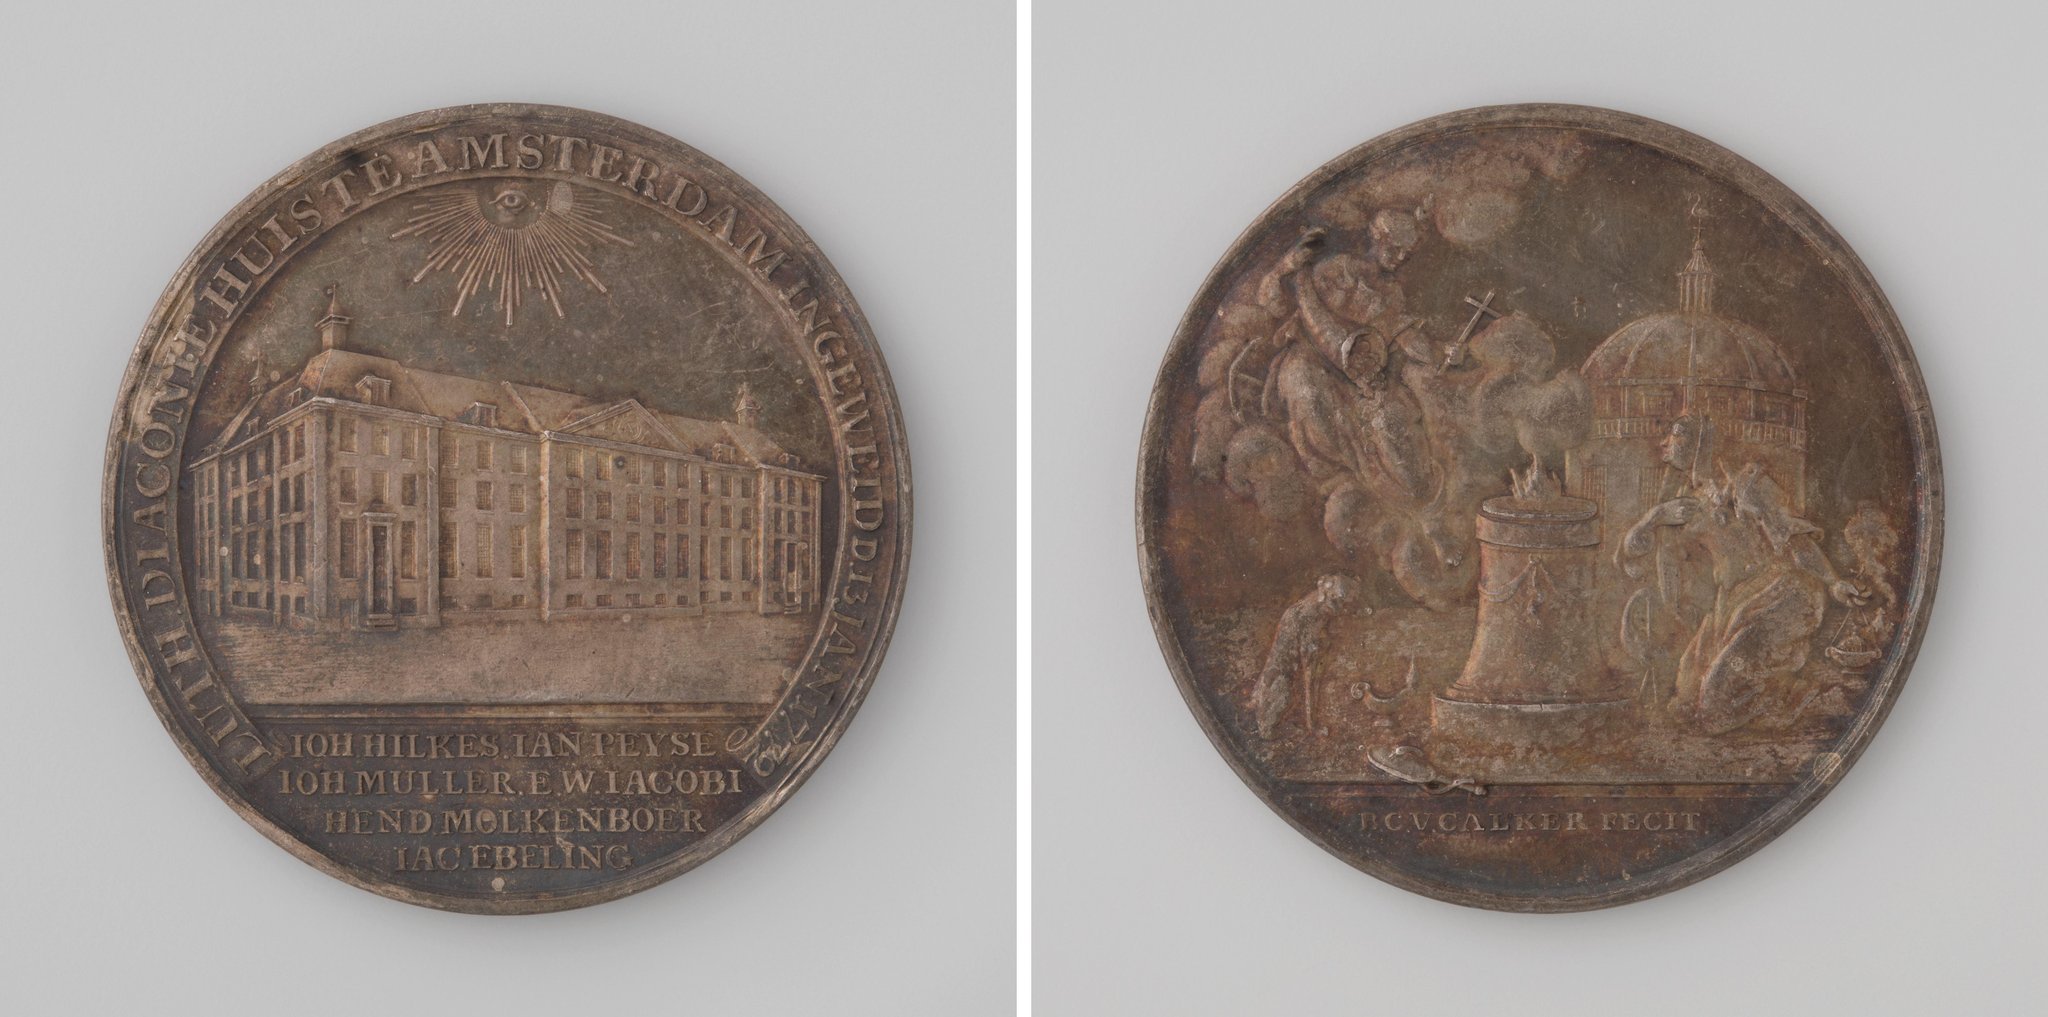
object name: history medal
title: Inwijding van het Luthers diaconiehuis te Amsterdam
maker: barend christiaan van calker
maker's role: medailleur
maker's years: 1739-1813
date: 1772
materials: silver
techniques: striking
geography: zeist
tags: johannes hilkes, jan peyse, johannes muller, e.w. iacobi, hendrik molkenboer, jacob ebeling, lutherse diaconiehuis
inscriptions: circumscription: ‘LUTH. DIACONIE HUIS TE AMSTERDAM INGEWEID 13 JAN 1772’, caption: ‘IOH. HILKERS. IAN PEYSE/ IOH. MULLER. E.W. IACOBI/ HEND. MOKENBOER/ IAC. EBELING’, signature: ‘B.C.V. CALKER FECIT.’